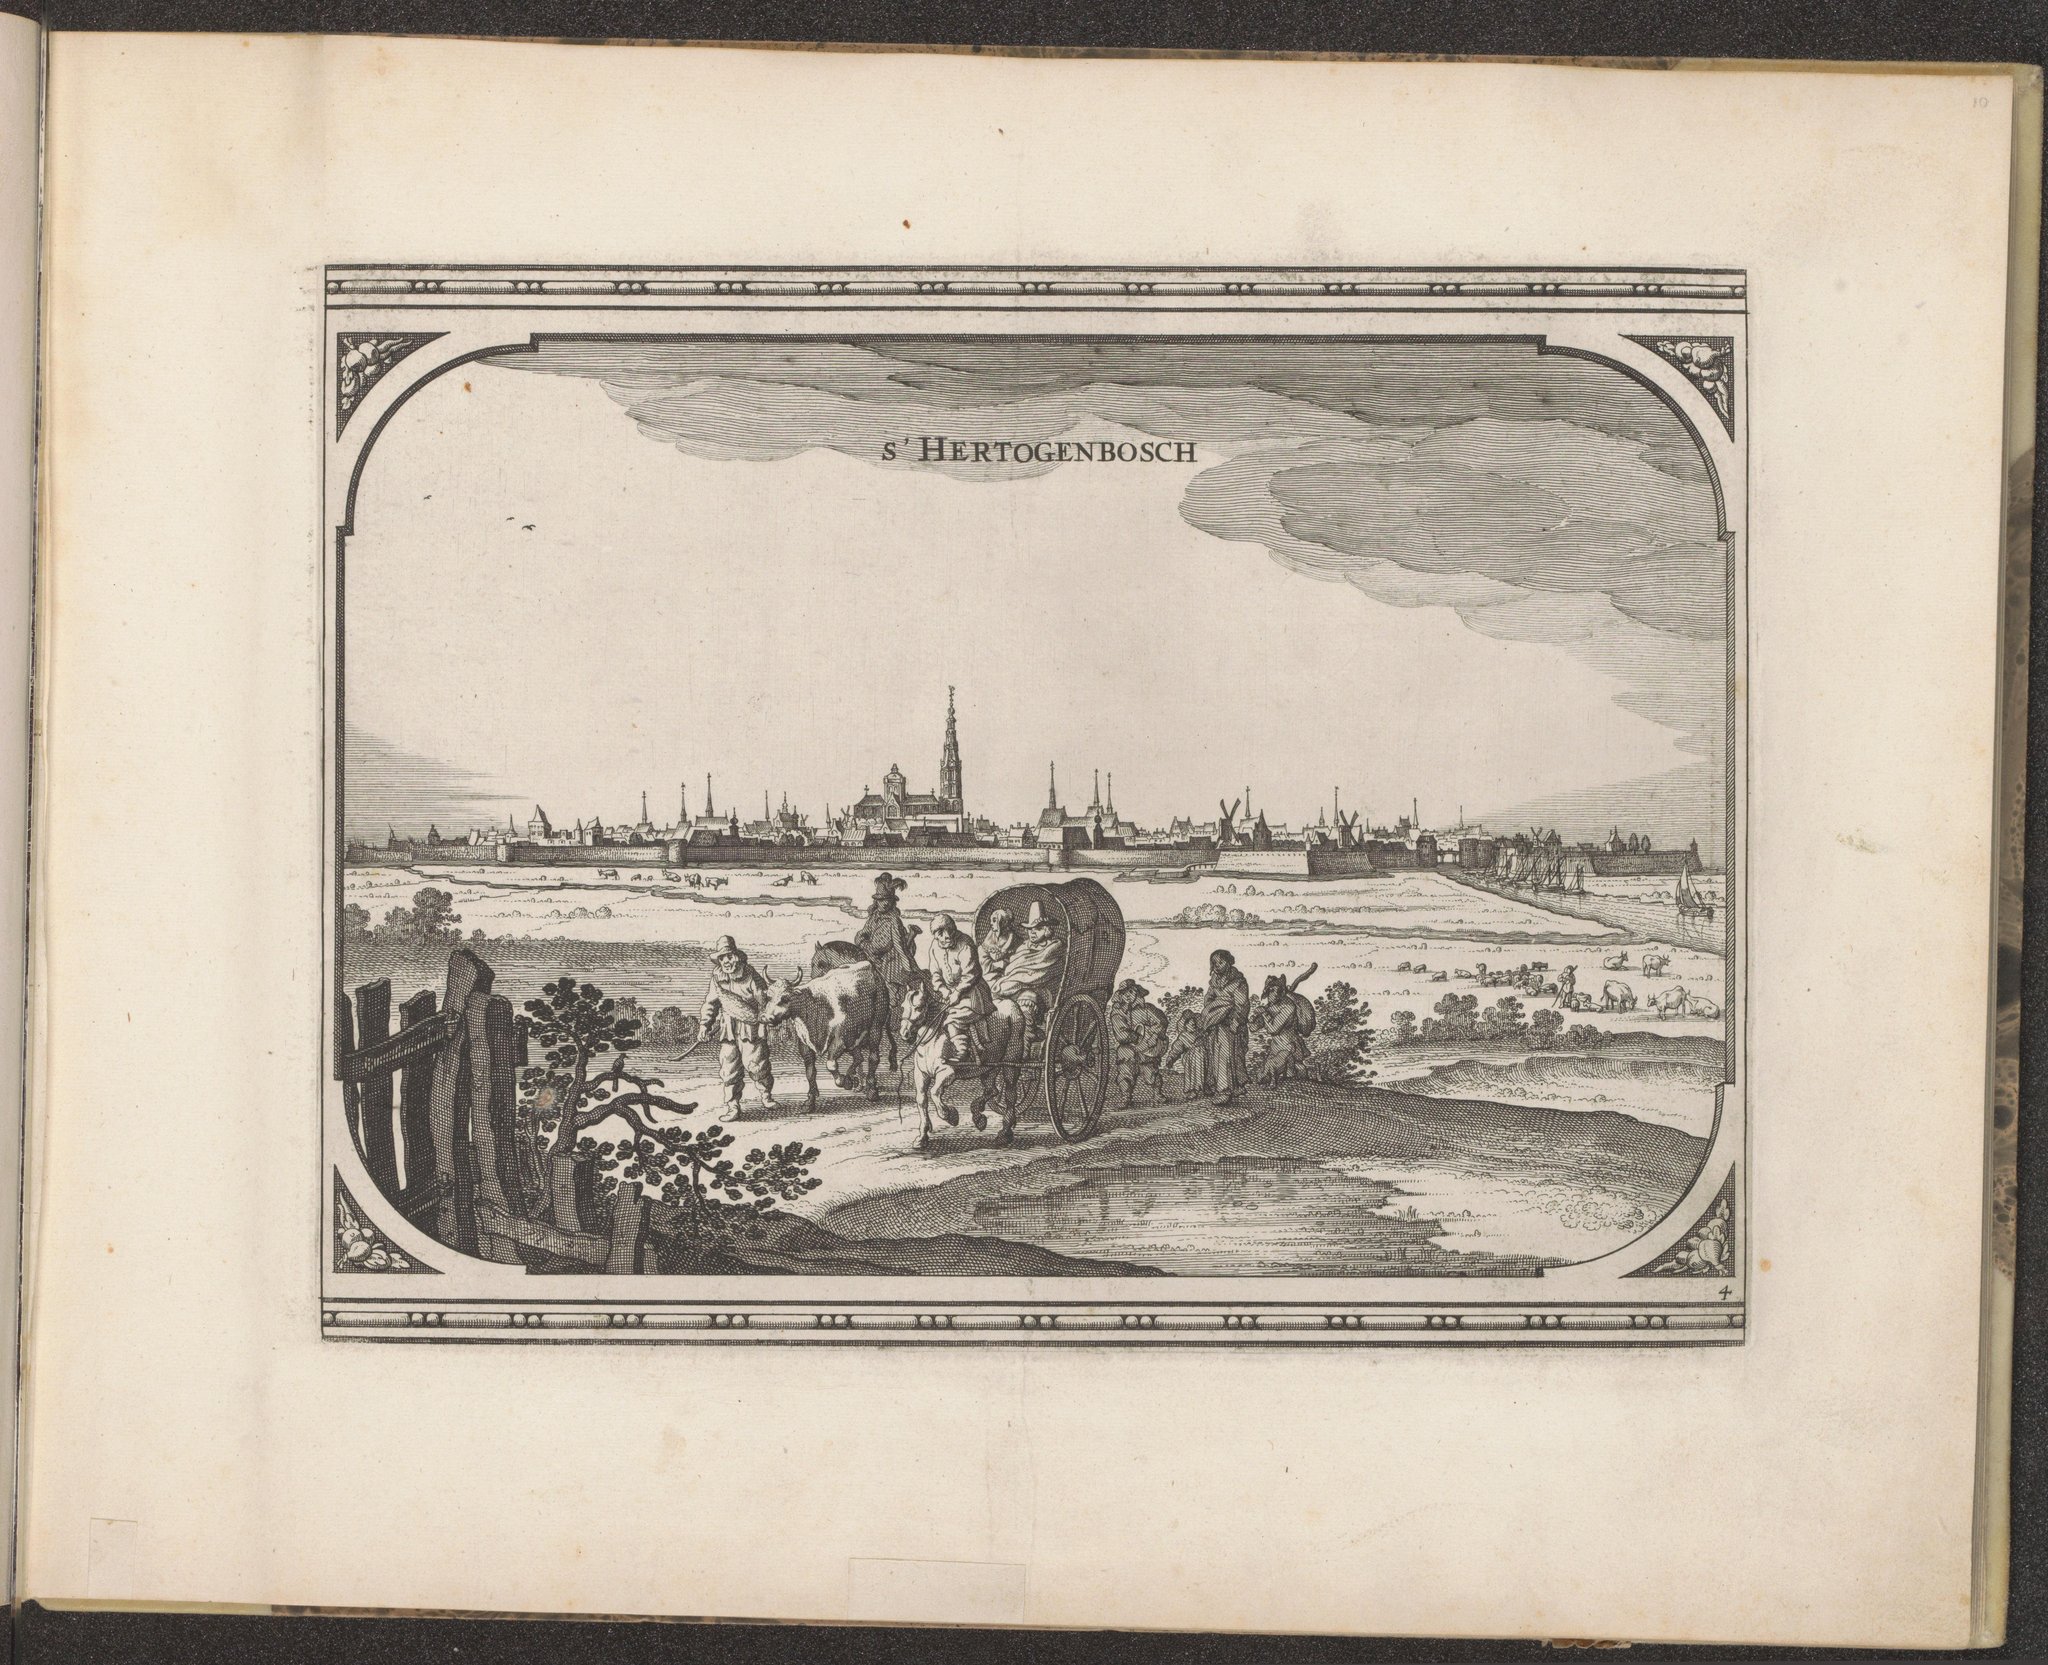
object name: album leaf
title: Theatrum praecipuarum urbium ducatus Brabantiae necnon comitatuum Flandriae et Zelandiae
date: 1660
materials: paper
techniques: etching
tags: animal traction, animal-drawn vehicle (carriage etc.), city-view, and landscape with man-made constructions, den bosch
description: Gezicht op de stad Den Bosch. Op de voorgrond onder andere een ruiter, een man met een os en een huifkar. De prent maakt deel uit van een album.